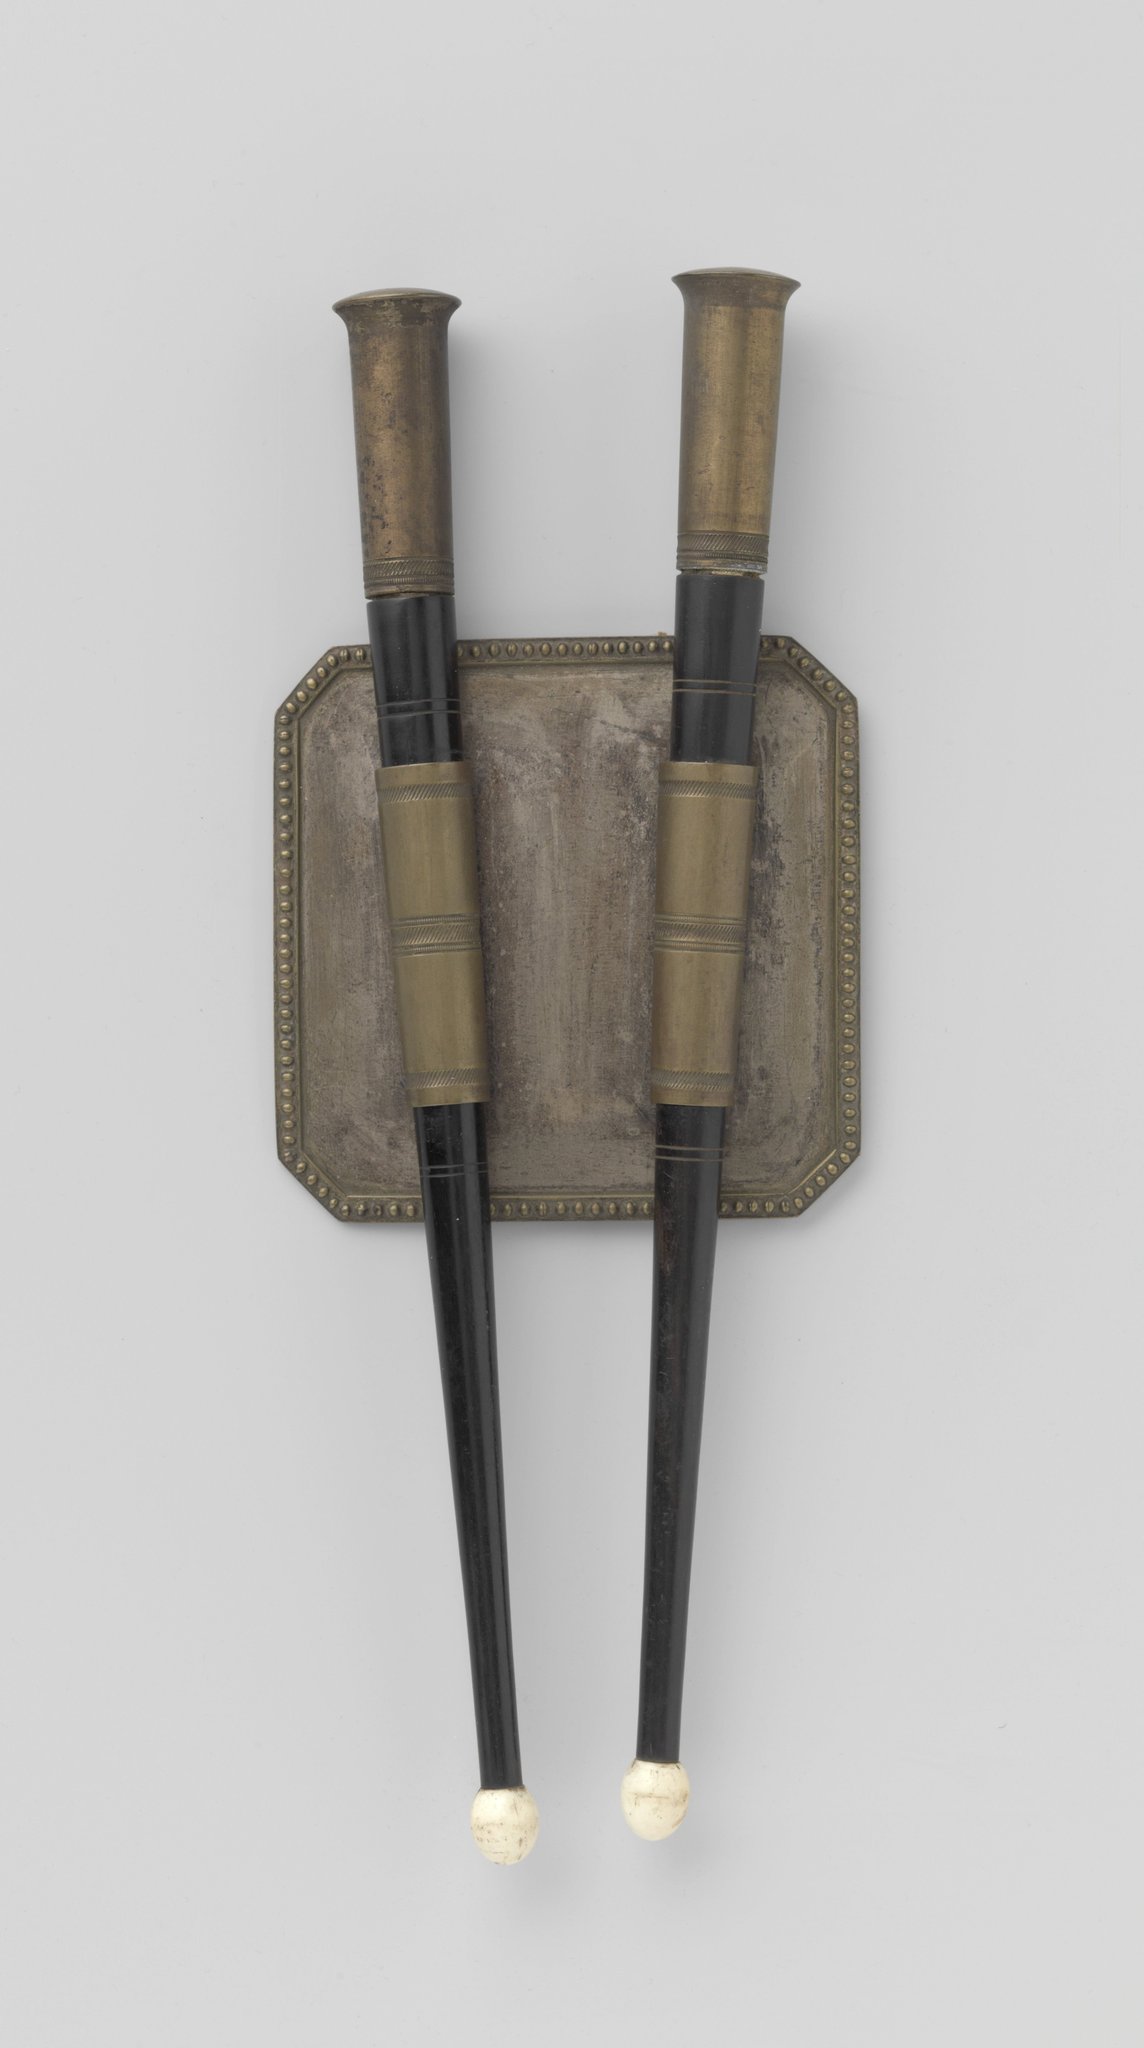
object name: beater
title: Drumsticks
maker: Anonymous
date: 1823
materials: copper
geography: netherlands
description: Stokplaat van messing en trommelstokken voor tamboer-majoor.